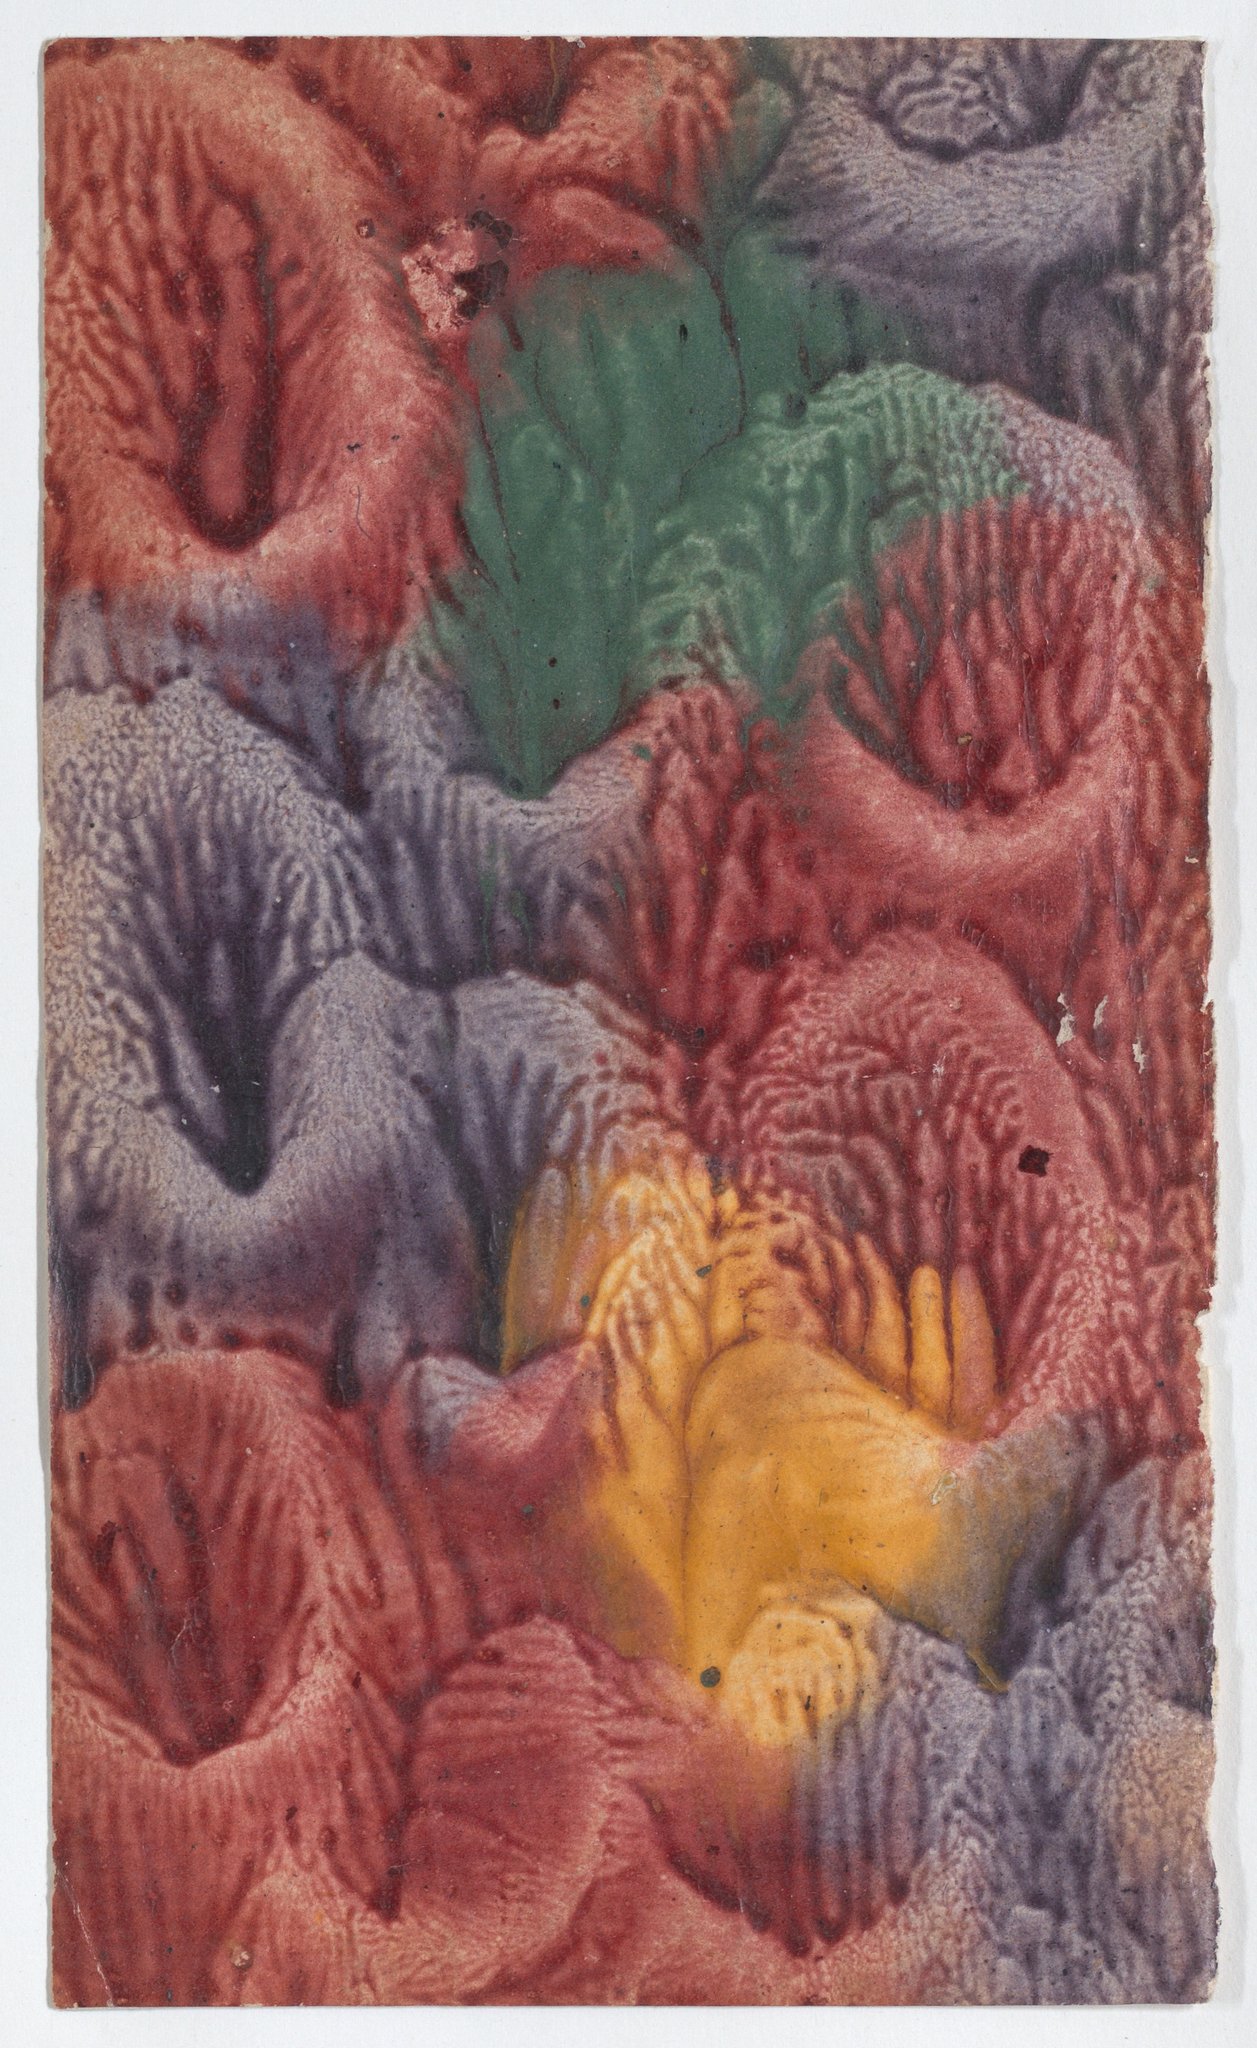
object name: print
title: Paste paper with red, yellow, green, and purple patterns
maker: Anonymous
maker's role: artist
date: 1701-1800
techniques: relief print